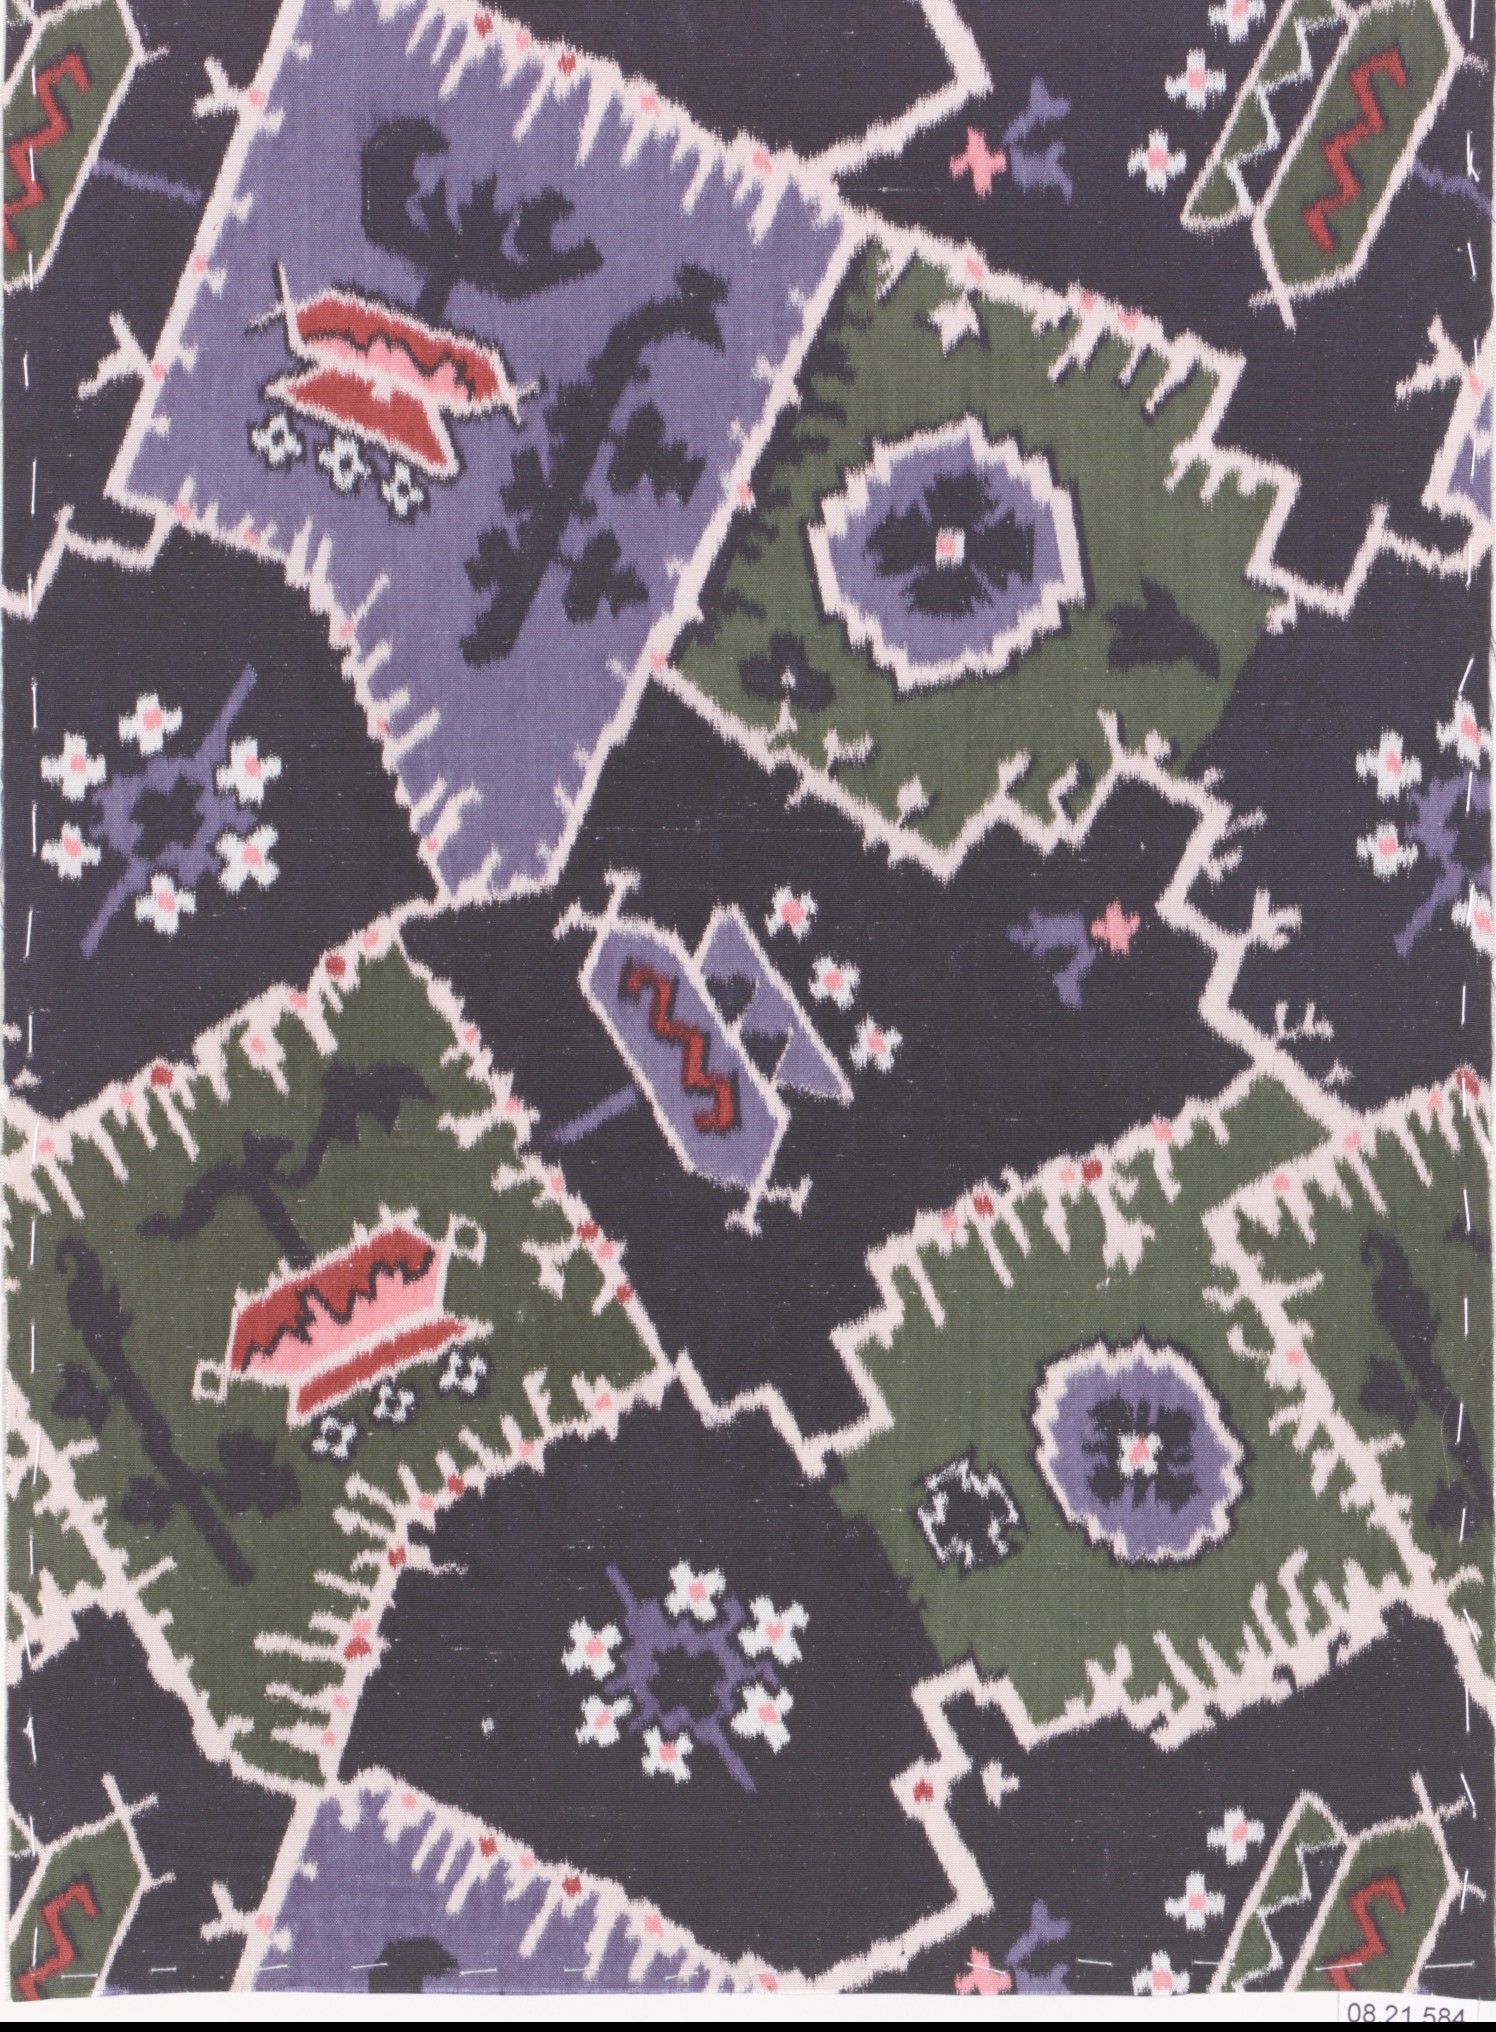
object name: textile sample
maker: Anonymous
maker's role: designer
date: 1900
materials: silk